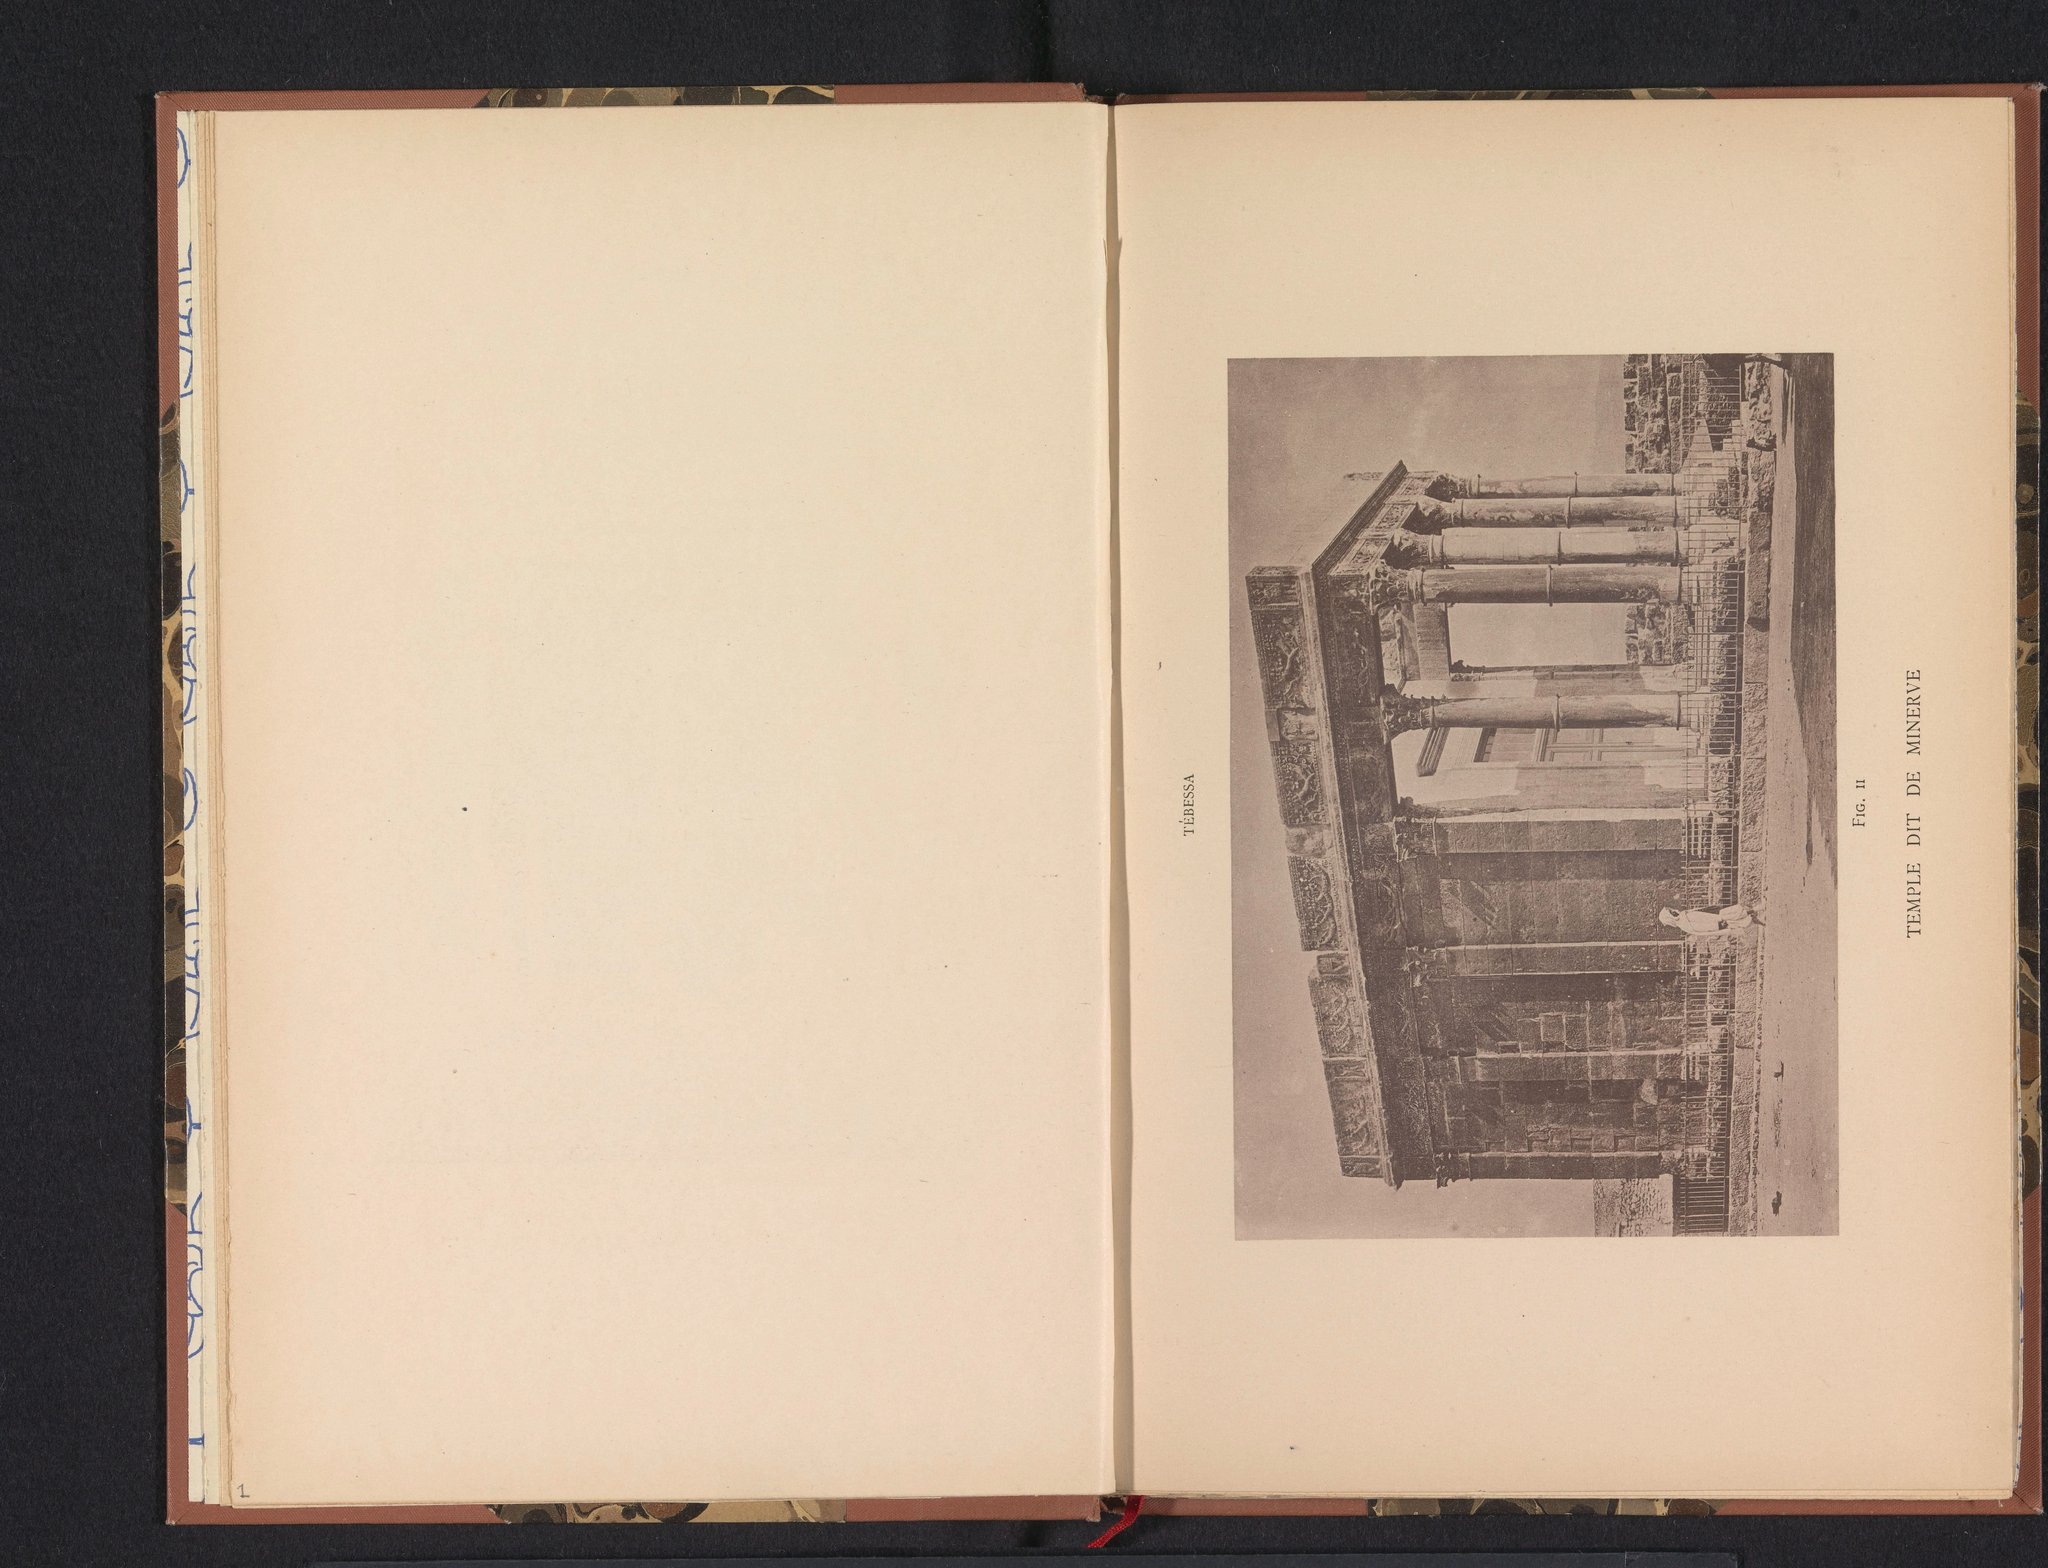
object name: page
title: Gezicht op de de Minervatempel in Tébessa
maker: Anonymous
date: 1884-1894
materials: paper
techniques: photograph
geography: tébessa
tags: temple, shrine ~ roman religion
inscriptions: number: ‘Fig. II’